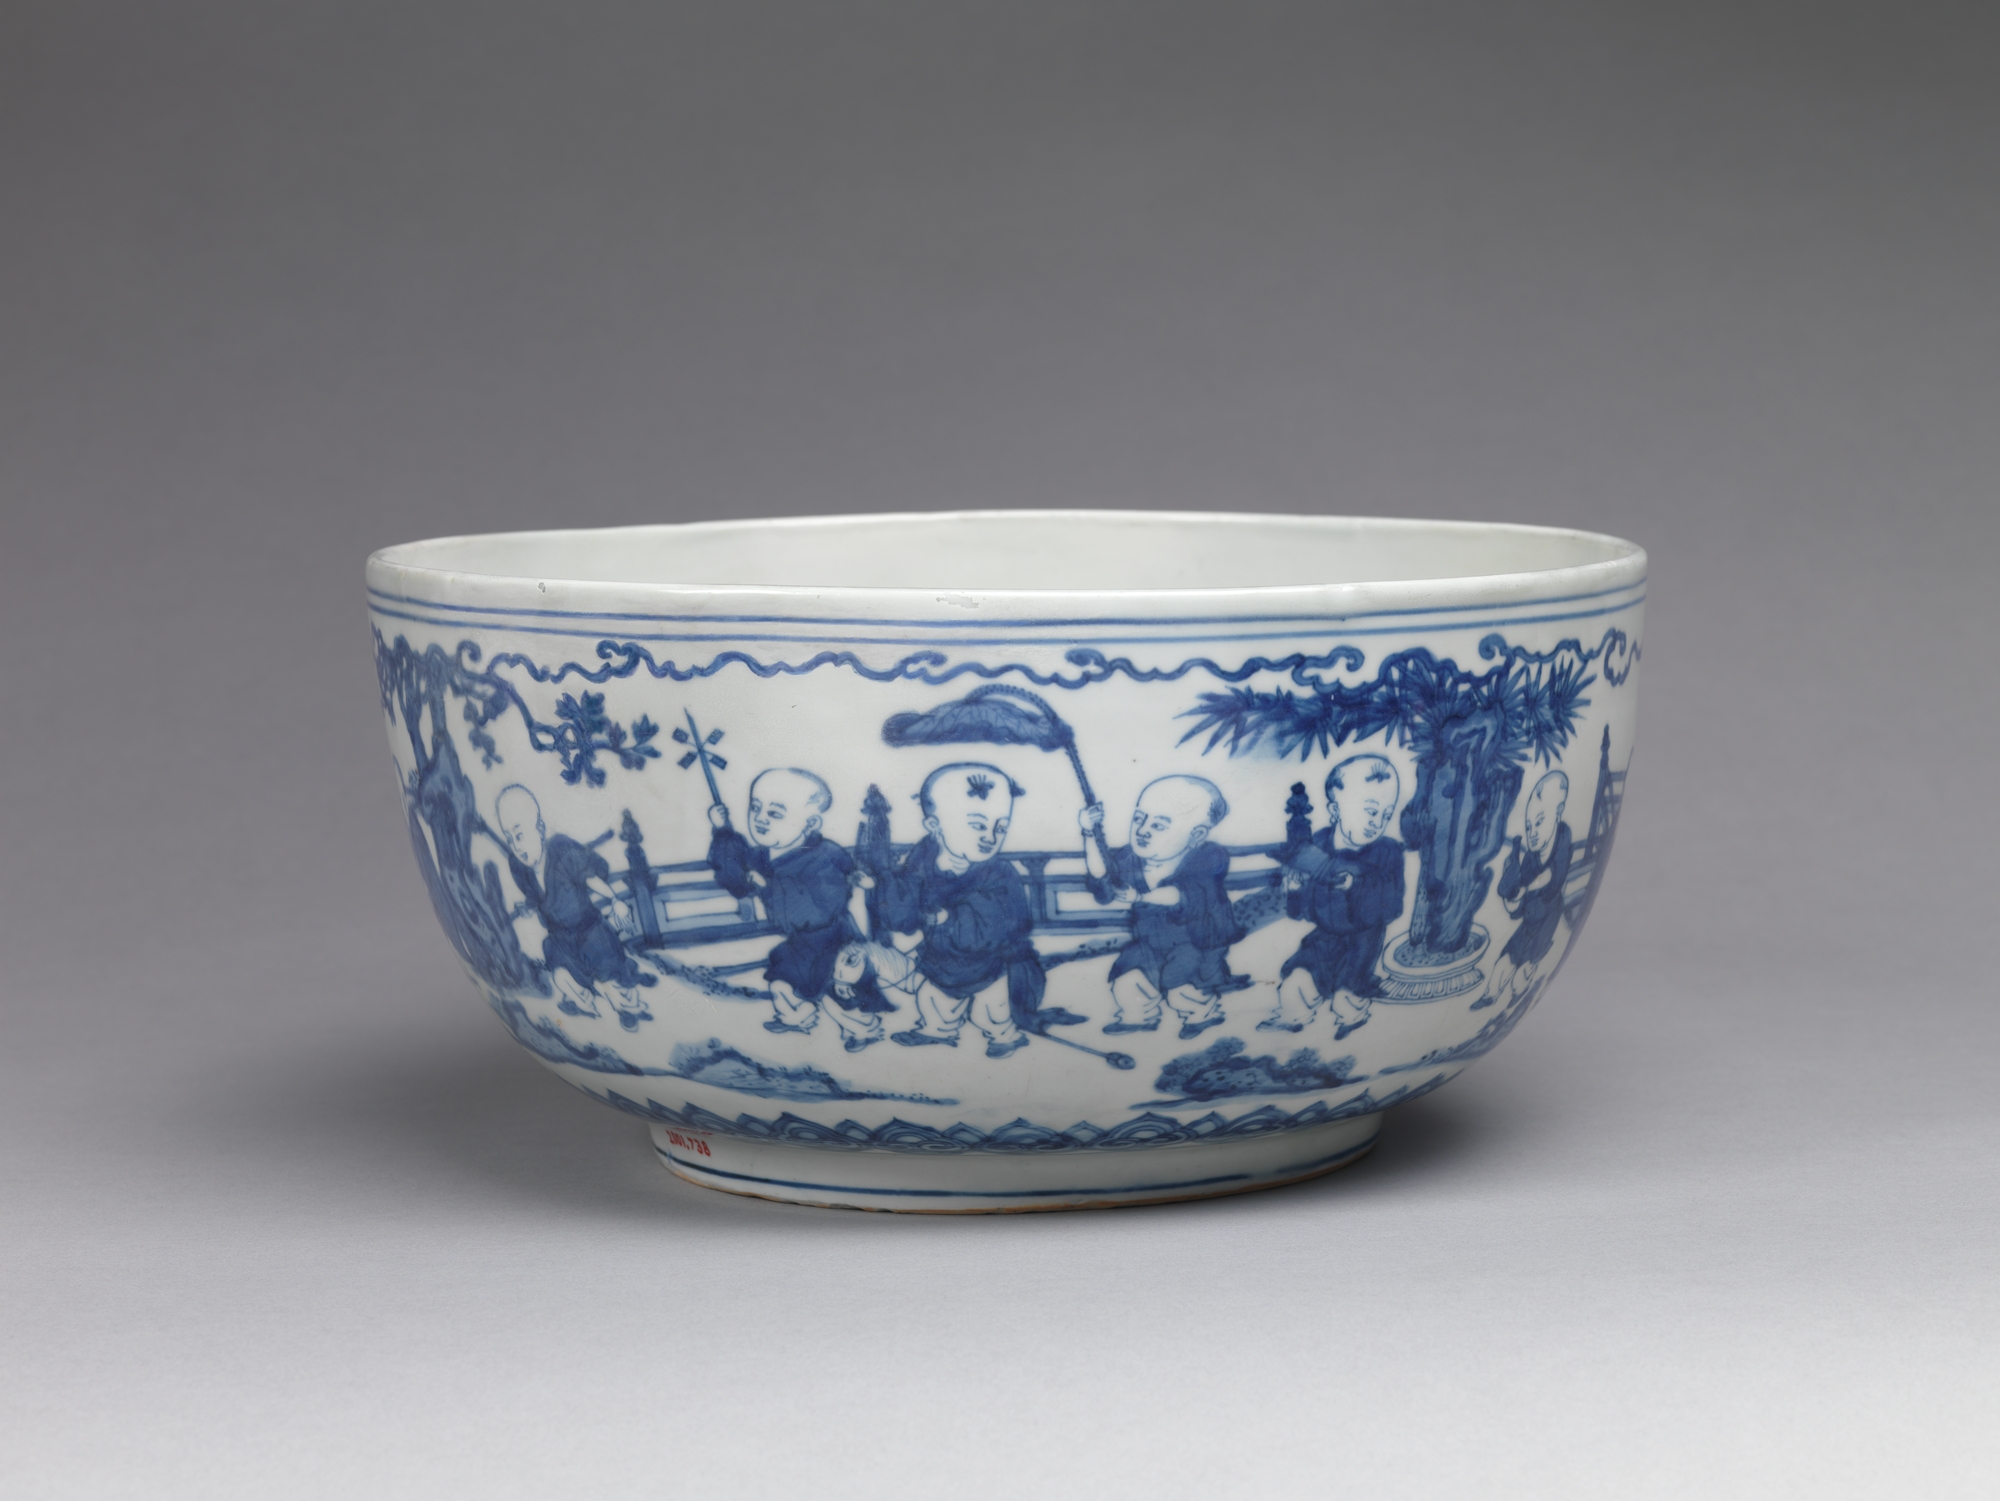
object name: bowl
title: Bowl with children in a garden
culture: chinese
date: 1534-1566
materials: cobalt, porcelain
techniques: painting, underglaze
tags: gardens,playing